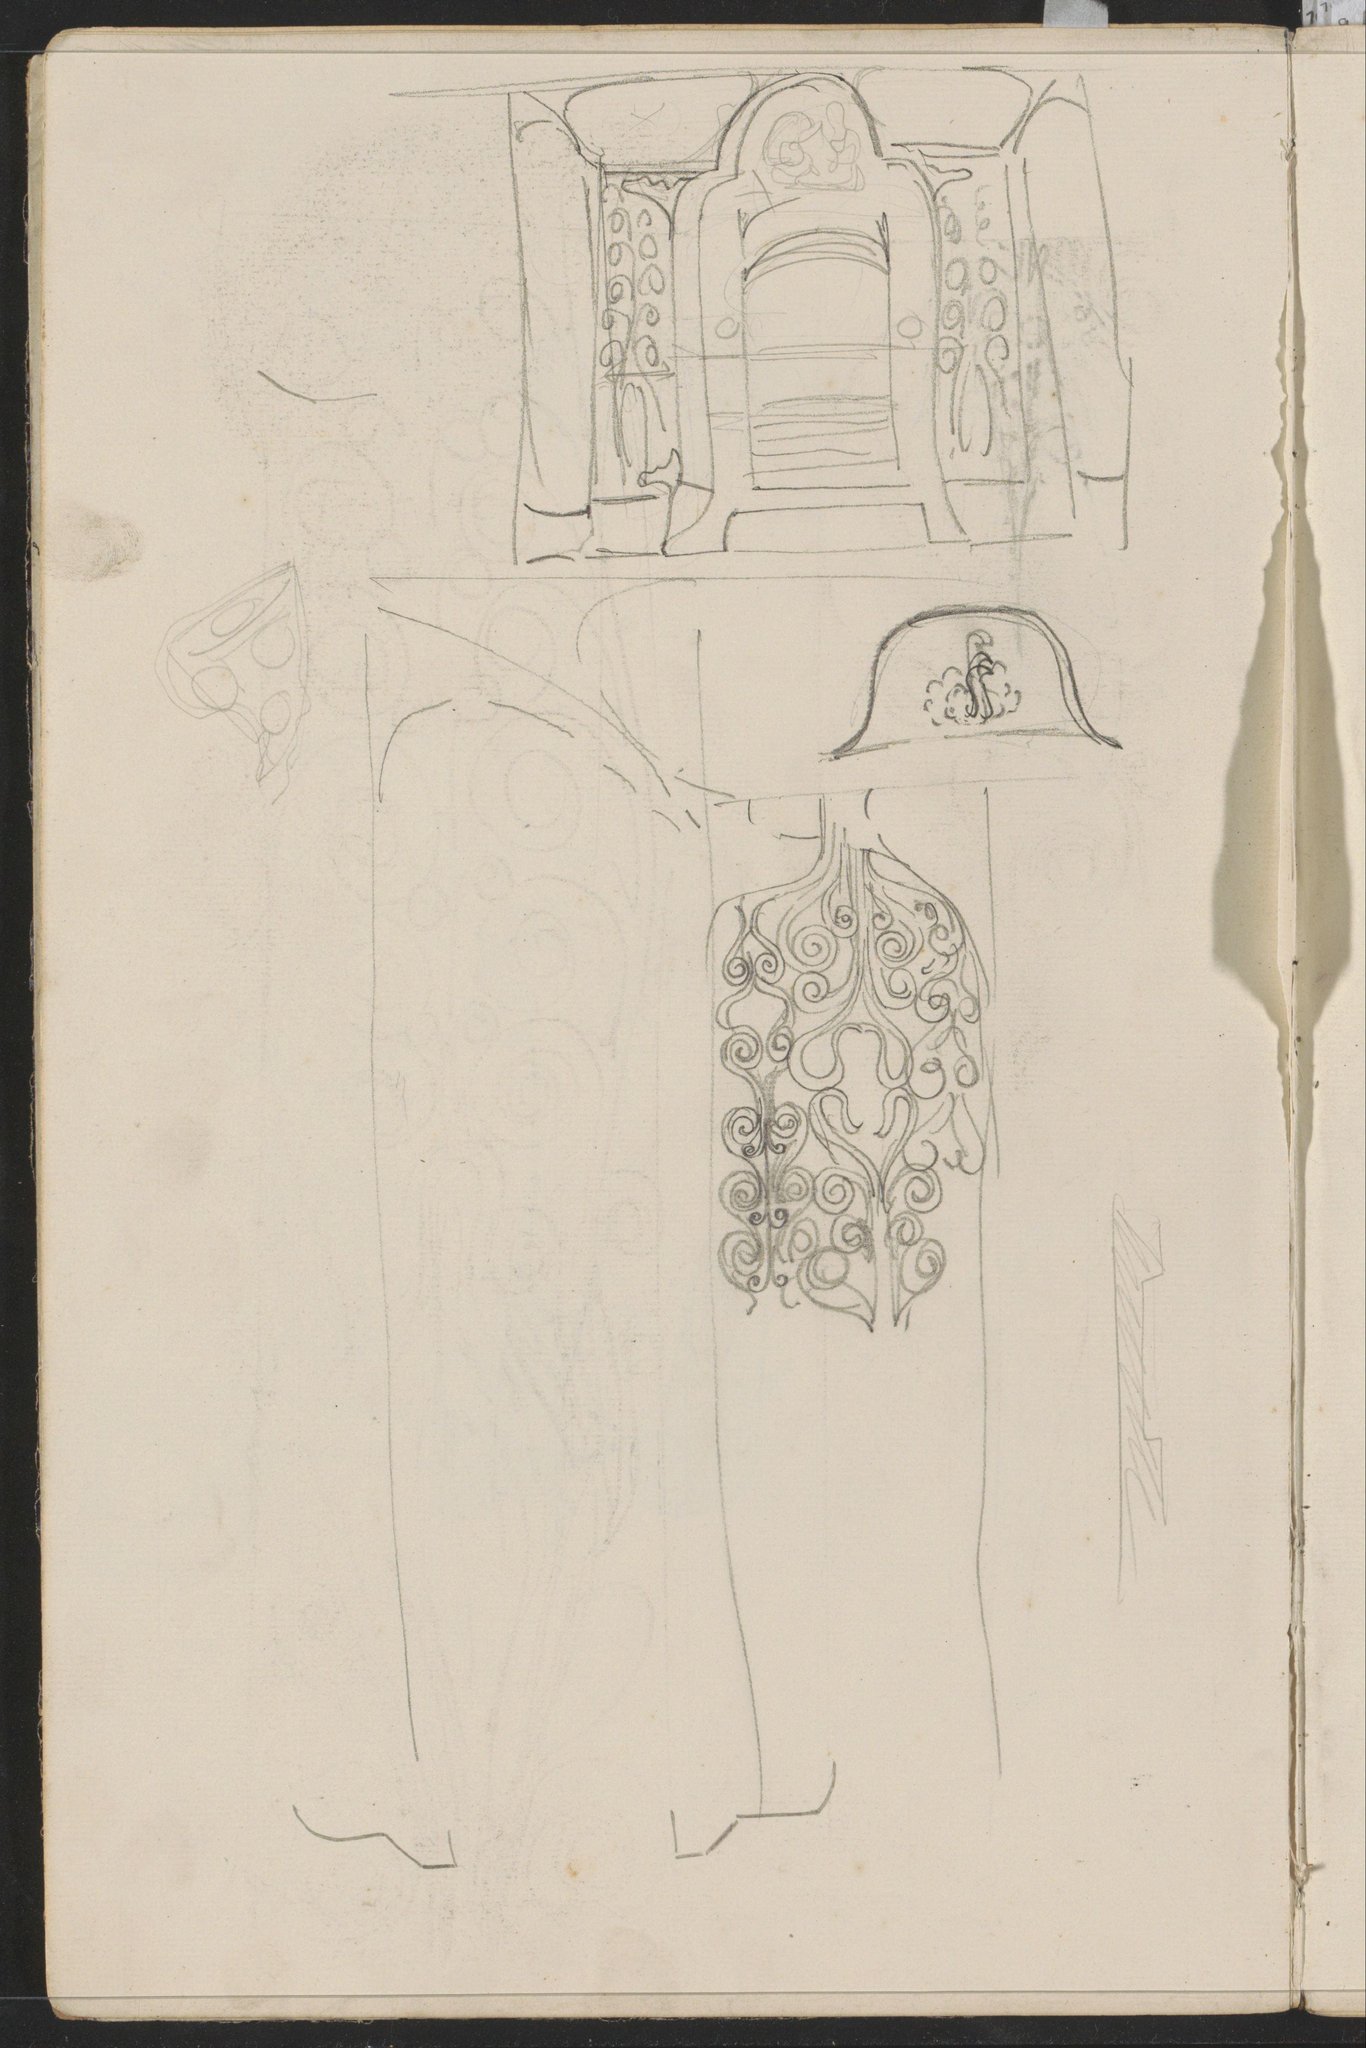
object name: sketchbook leaf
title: Ornamentontwerpen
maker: carel adolph lion cachet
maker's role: draughtsman, print maker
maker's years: 1864-1945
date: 1897-1898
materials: paper, pencil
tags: ornaments ~ art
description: Blad 5 verso uit een schetsboek met 29 bladen.